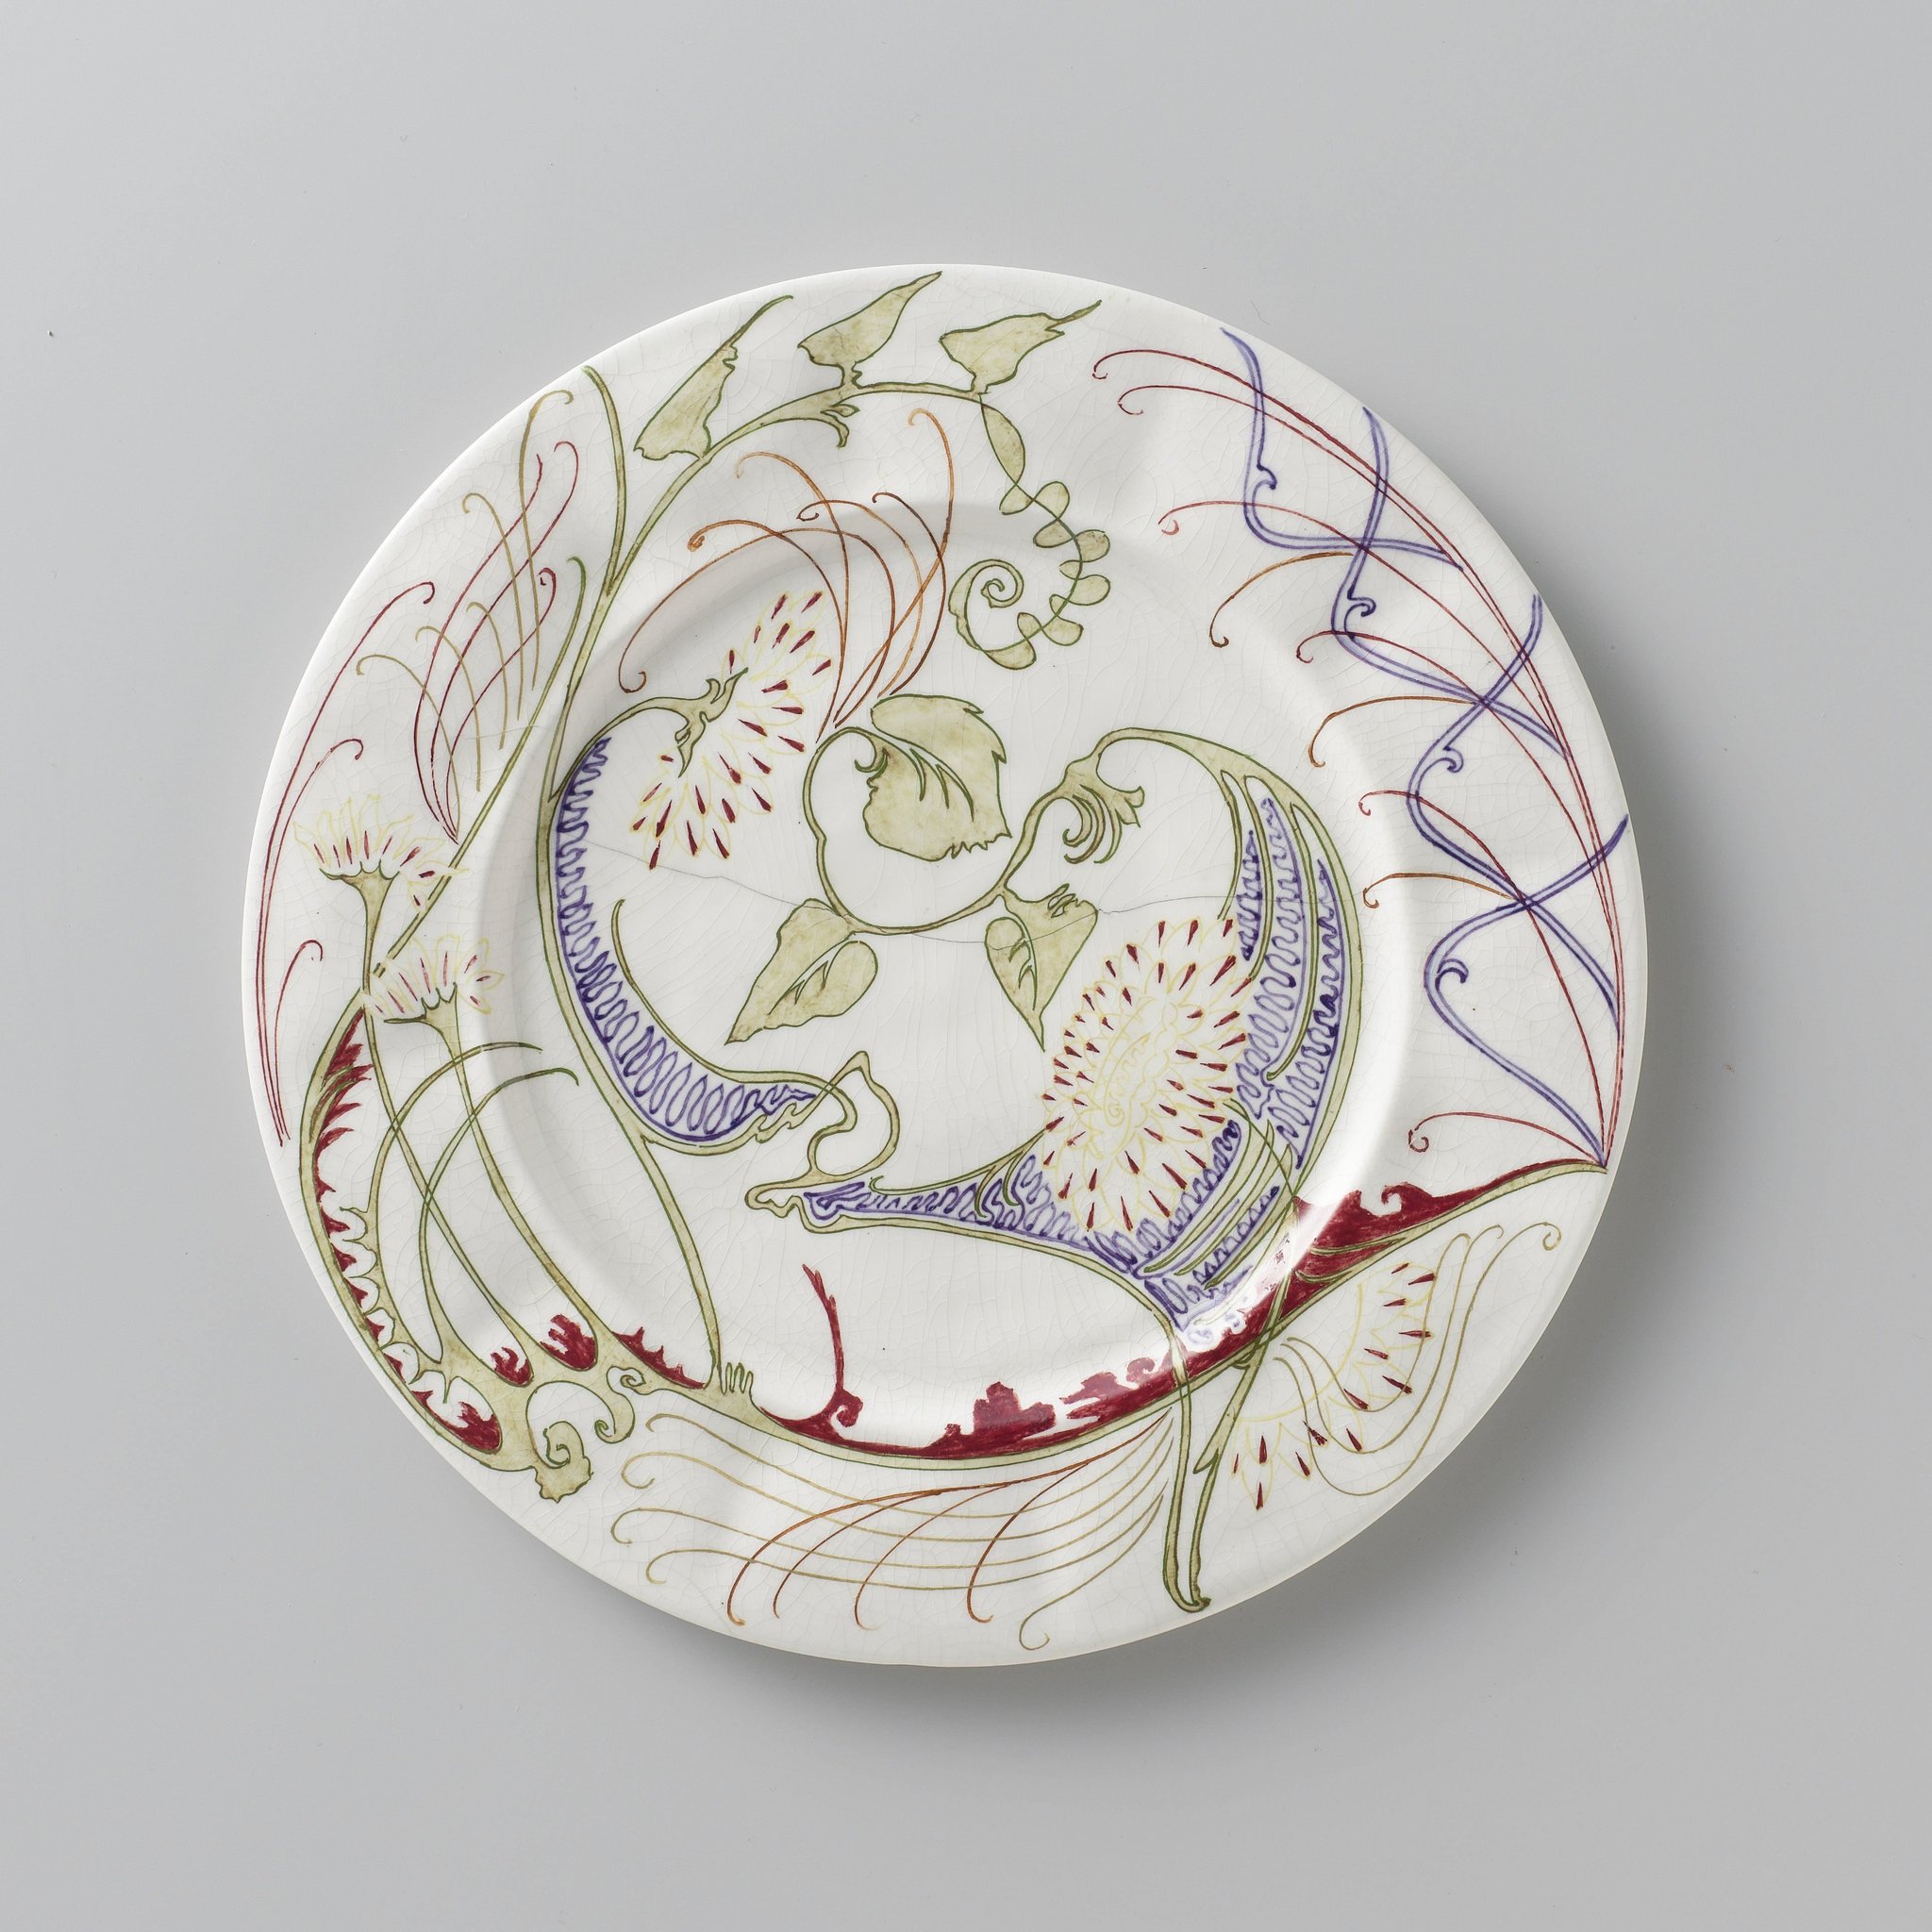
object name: plate dish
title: Bord versierd met gestileerd bloem- en bladwerk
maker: sam schellink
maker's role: ceramicist, draughtsman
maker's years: 1876-1958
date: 1899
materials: porcelain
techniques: firing, painted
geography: the hague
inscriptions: mark: ‘in grijsgroen boven elkaar: Rozenburg, ooievaar, den Haag; links een anker (= 1899); rechts het werkordernummer 315 en de letter S met een schuine streep erdoor’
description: Plate. 1899, decorated by Samuel Schellink.